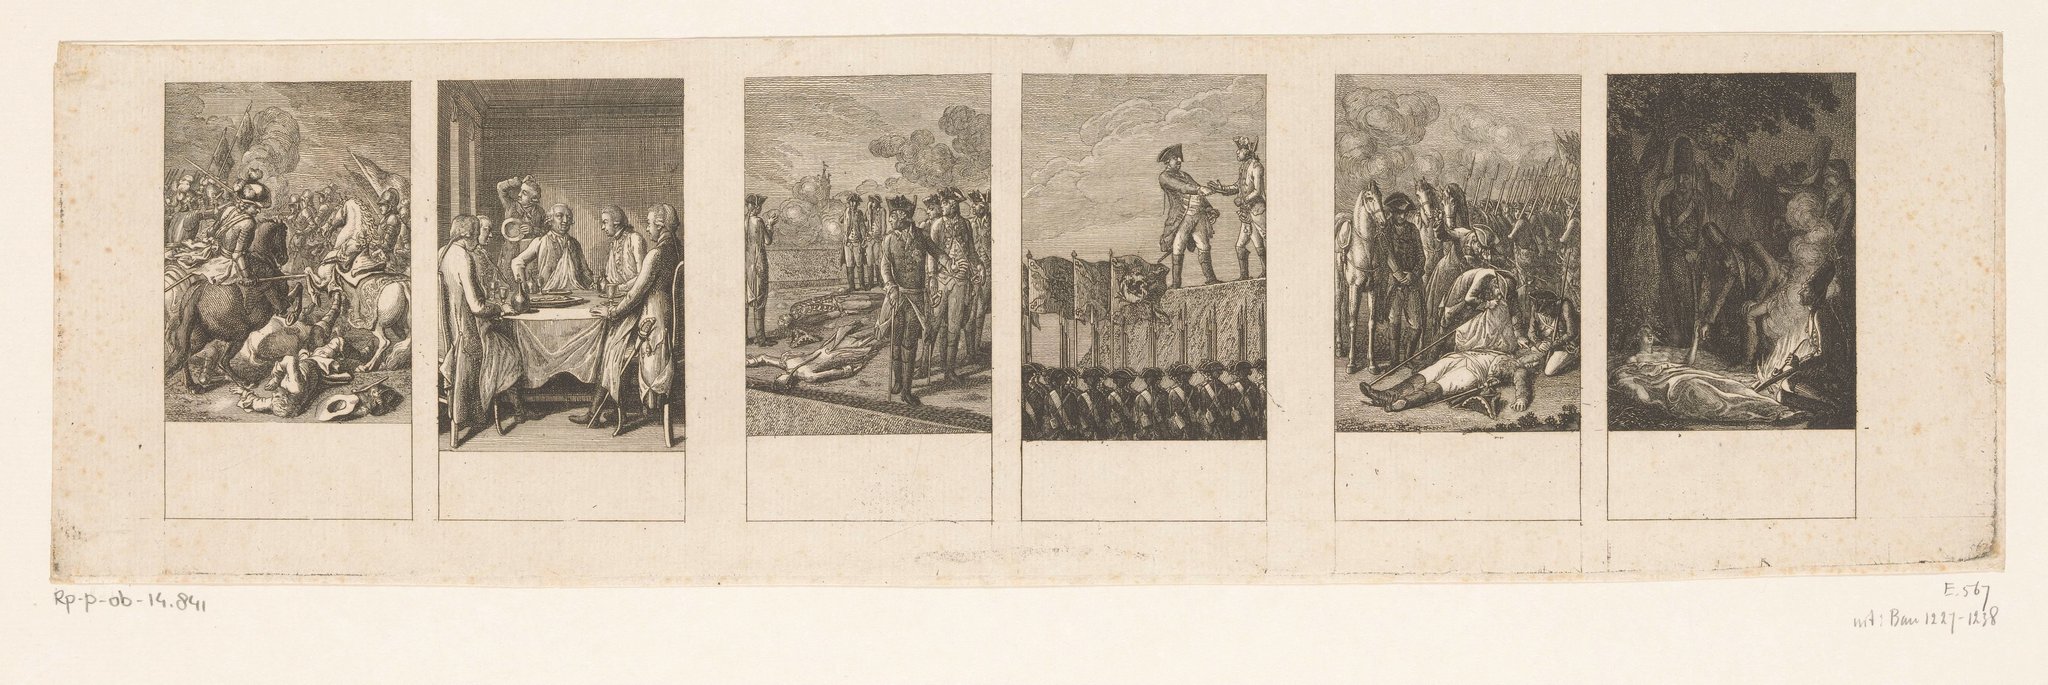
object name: print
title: Zes voorstellingen met Brandenburgse oorlogsscènes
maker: daniel nikolaus chodowiecki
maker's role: draughtsman, print maker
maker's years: 1726-1801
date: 1786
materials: paper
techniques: etching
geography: berlin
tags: trampling, treading, stamping on someone or something, commander-in-chief, general, marshal, deathbed, battle, evening meal, dinner, supper, horse, war, death of human being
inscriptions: collector's mark: Lugt 2228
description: Latere staat gebruikt voor: Genealogischer Militairischer Calender auf das Jahr 1787 (...). S.l.s.n.s.a.